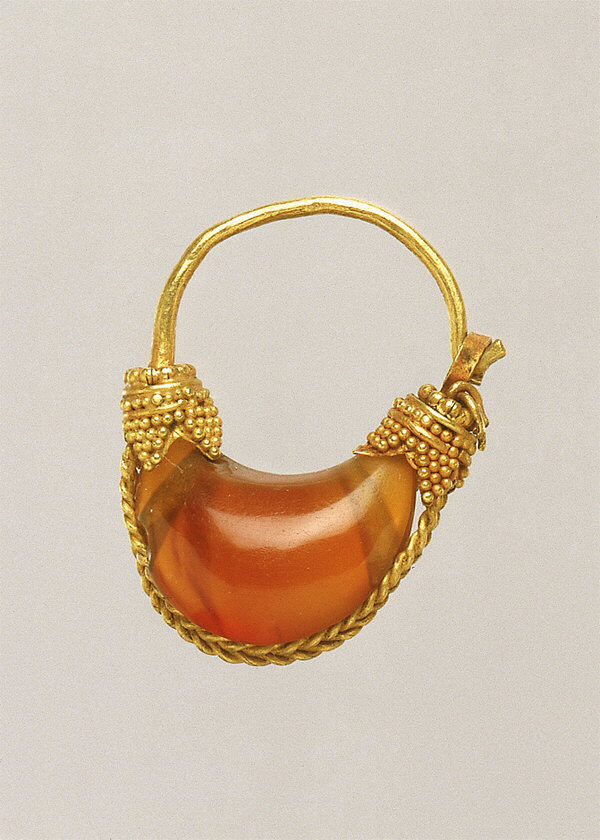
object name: earring, boat shaped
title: Gold and carnelian boat-shaped earring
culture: greek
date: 500-301 BCE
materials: gemstone, gold